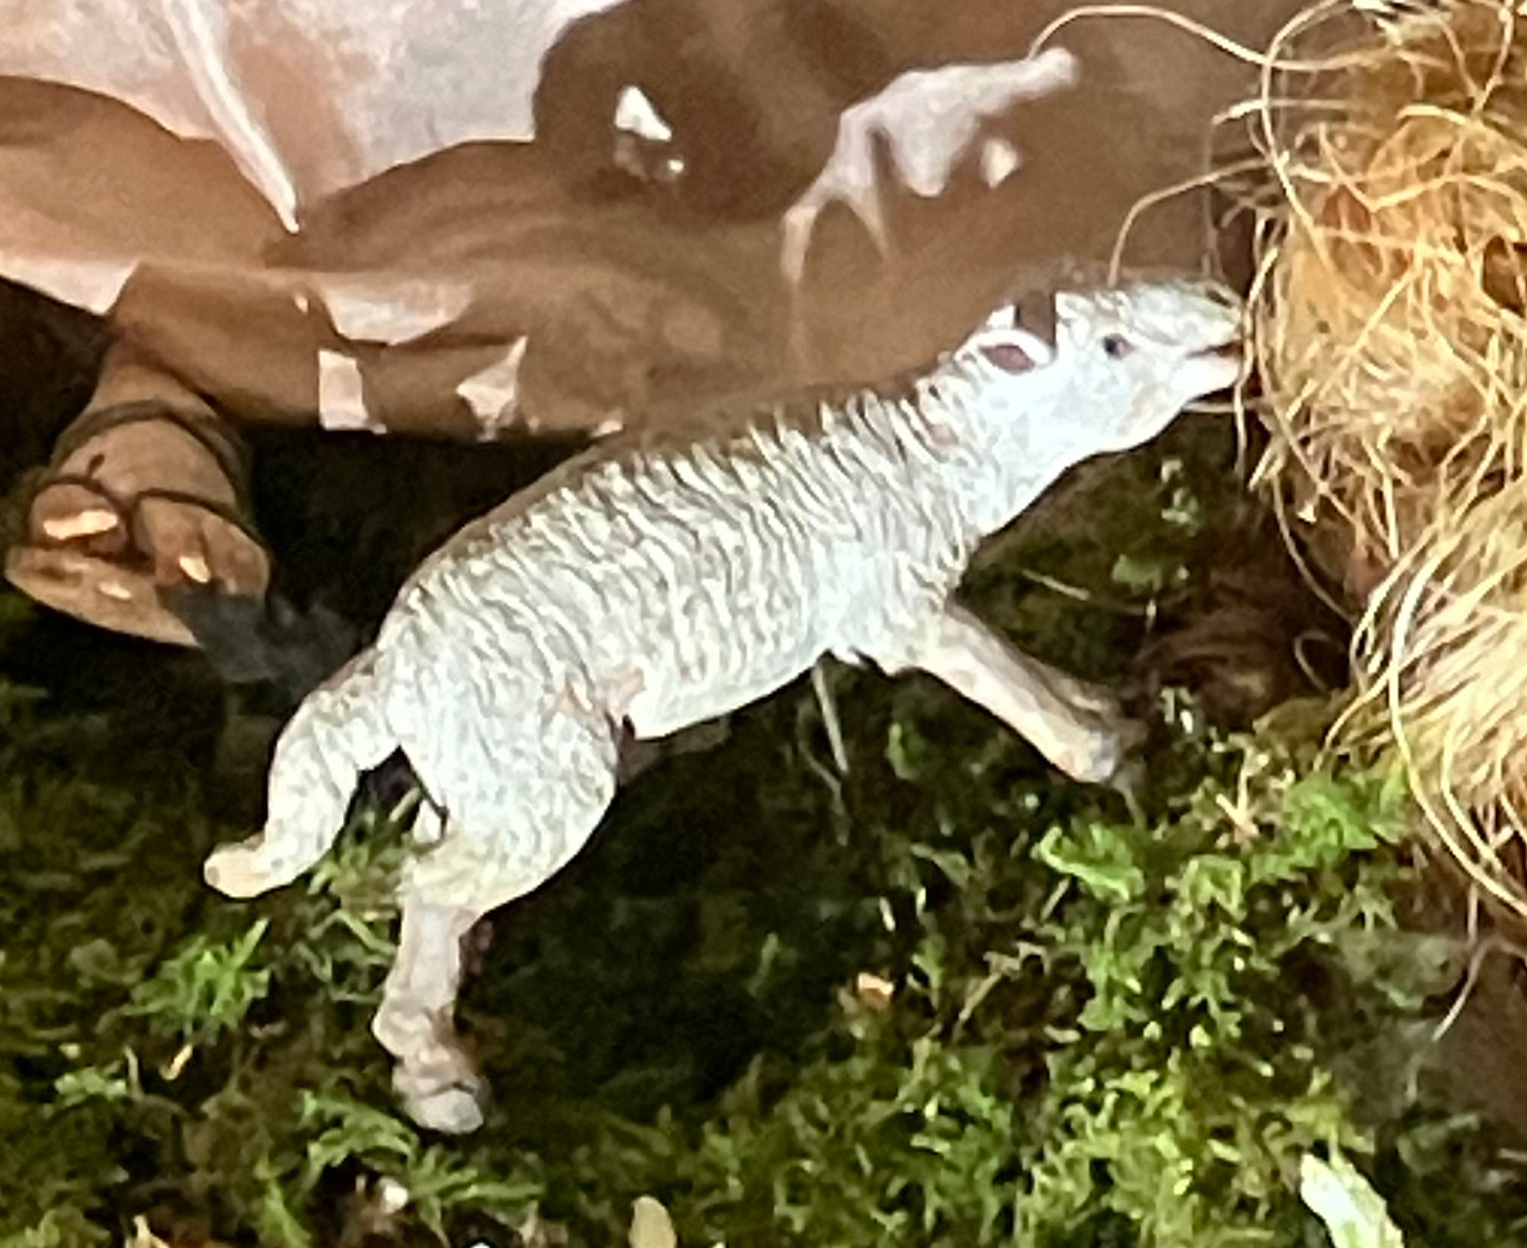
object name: crèche figure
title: Lamb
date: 1751-1800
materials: wood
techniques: polychrome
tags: lambs